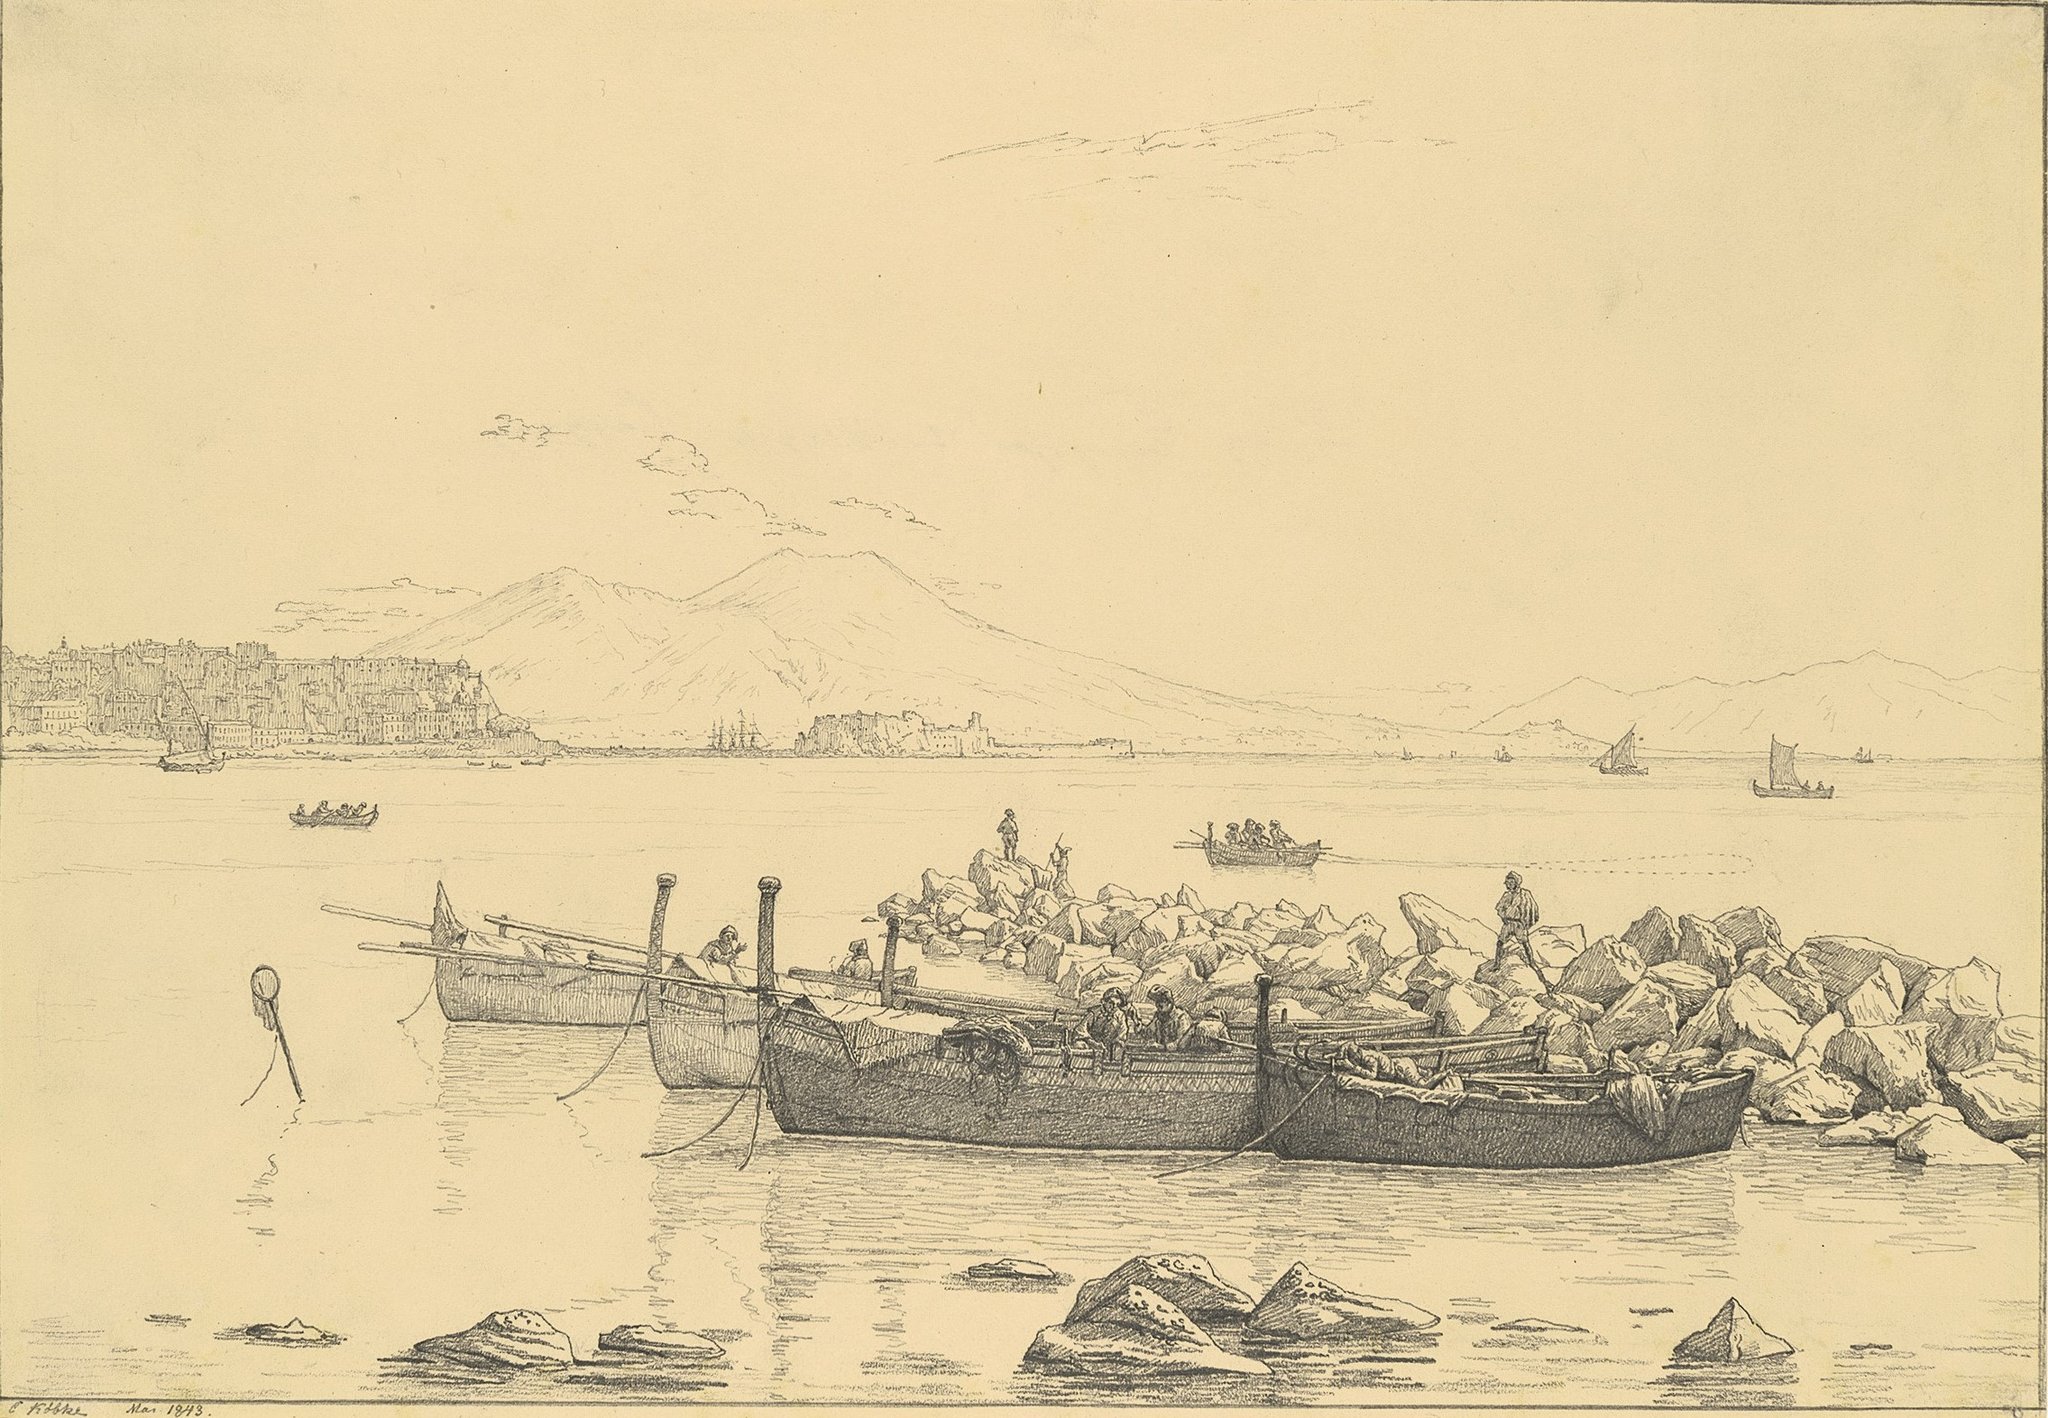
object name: drawing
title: The Bay of Naples with Vesuvius in the Background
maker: christen købke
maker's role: artist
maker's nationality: danish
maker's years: 1810-1848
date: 1843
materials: graphite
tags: boats